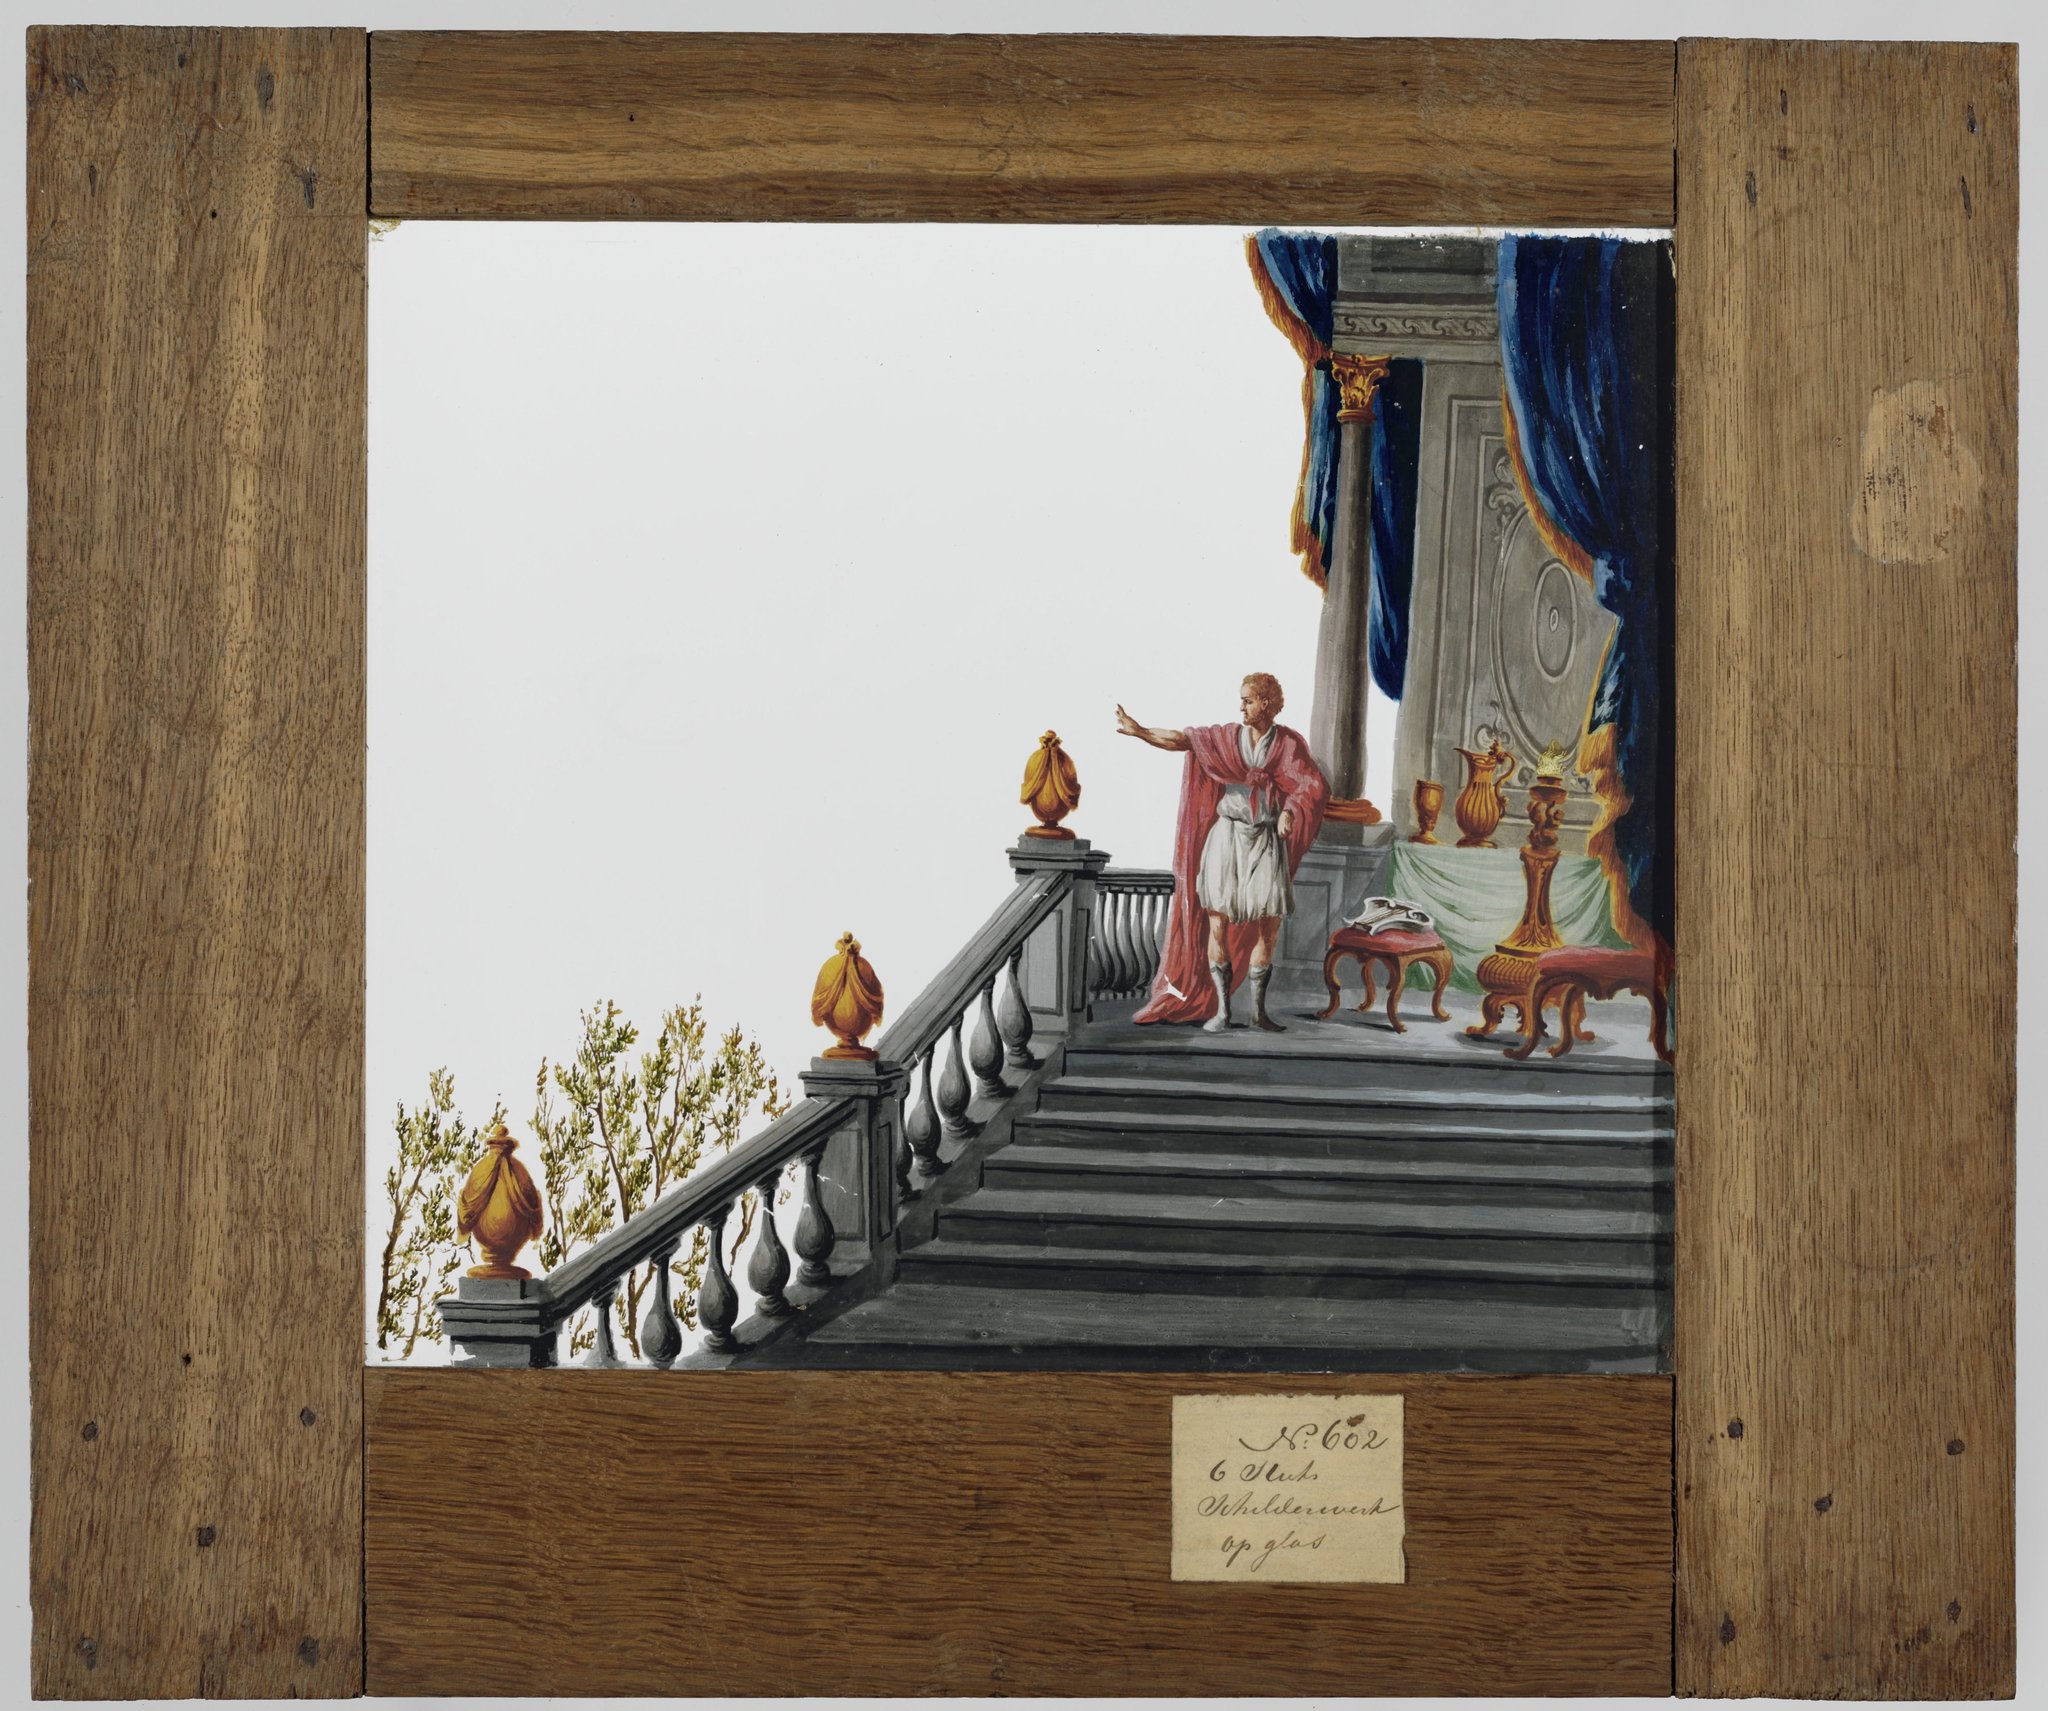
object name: diafanoramaplaat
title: Romeins heerser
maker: Anonymous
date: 1750-1830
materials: glass, wood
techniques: painted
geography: netherlands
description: Een Romeinse heerser in rode toga, waarschijnlijk keizer Nero, kijkt vanaf een platform bovenaan een trap en maakt een handgebaar. Achter hem een drinkkan en beker op een tafel. Op een kruk ligt een lier. Op het houten frame een sticker met de tekst: '6 stuks schilderwerk op glas'. Onderdeel van een serie platen die samen een diafanorama vormt van een brandende Romeinse stad en een toekijkende heerser, waarschijnlijk keizer Nero en de grote brand van Rome.